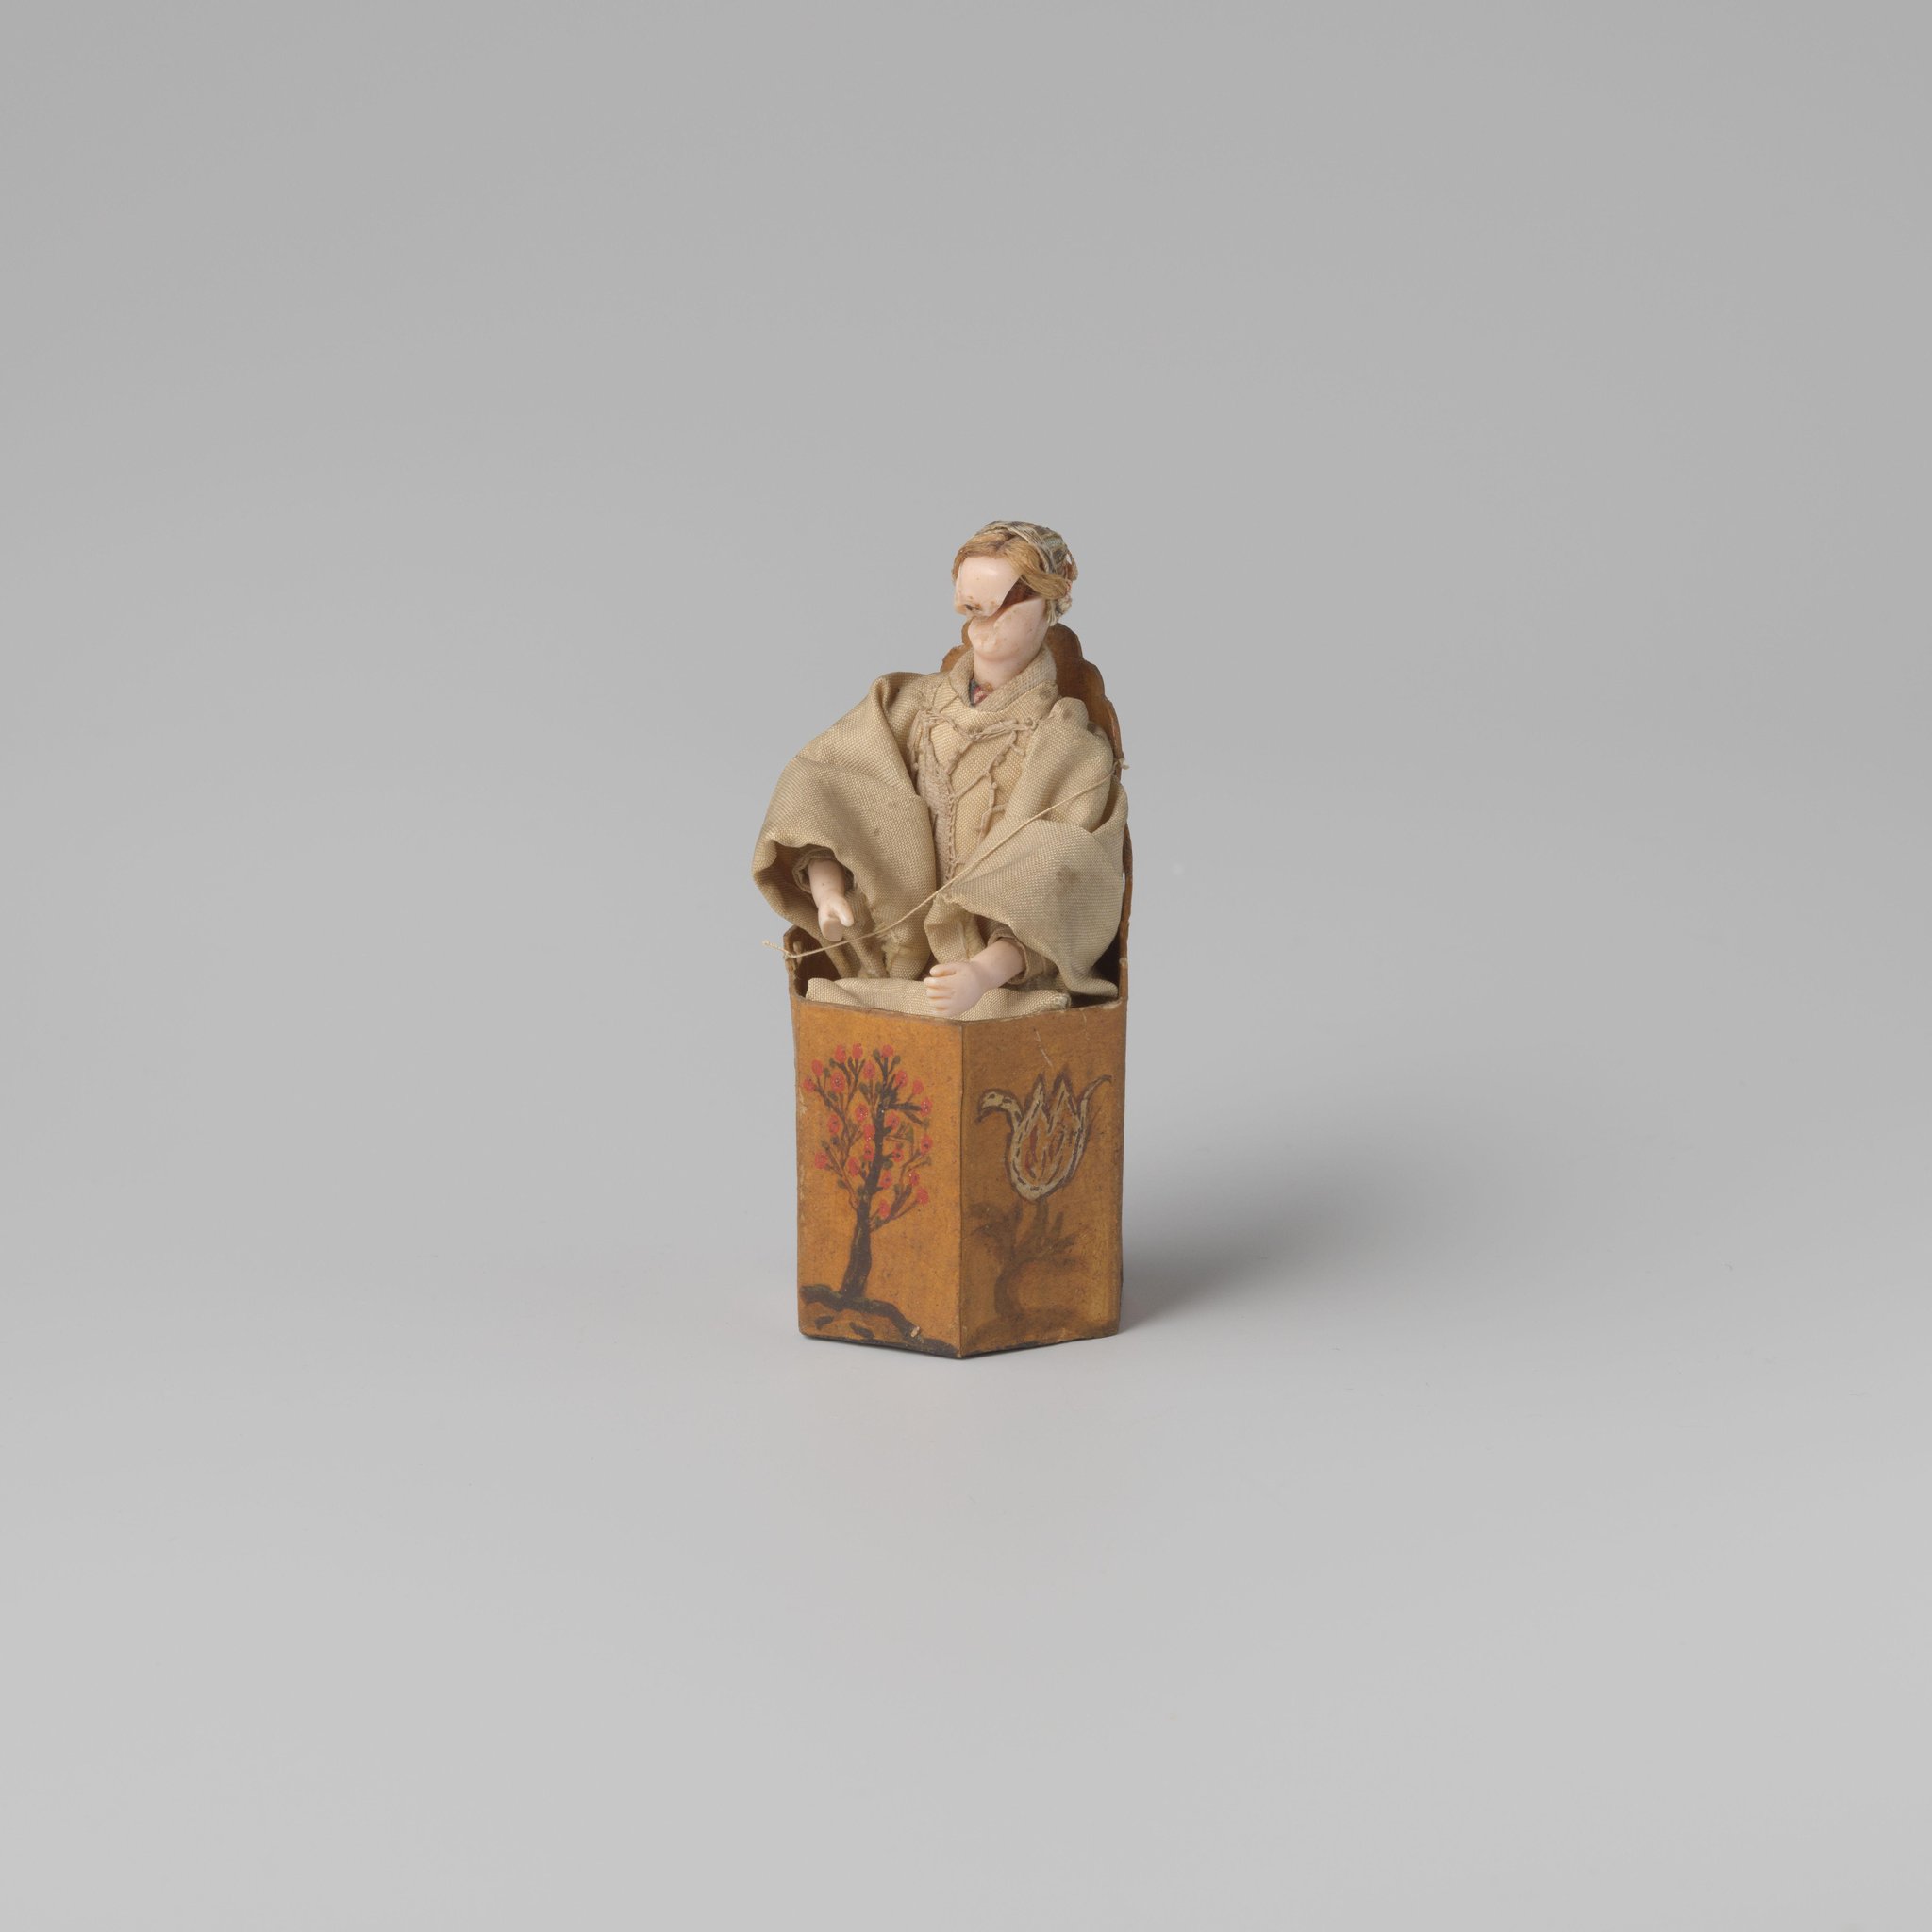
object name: miniature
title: Pop, voorstellende een kind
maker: Anonymous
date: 1676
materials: cotton, glass, hair, silk, fiber, wax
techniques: lace